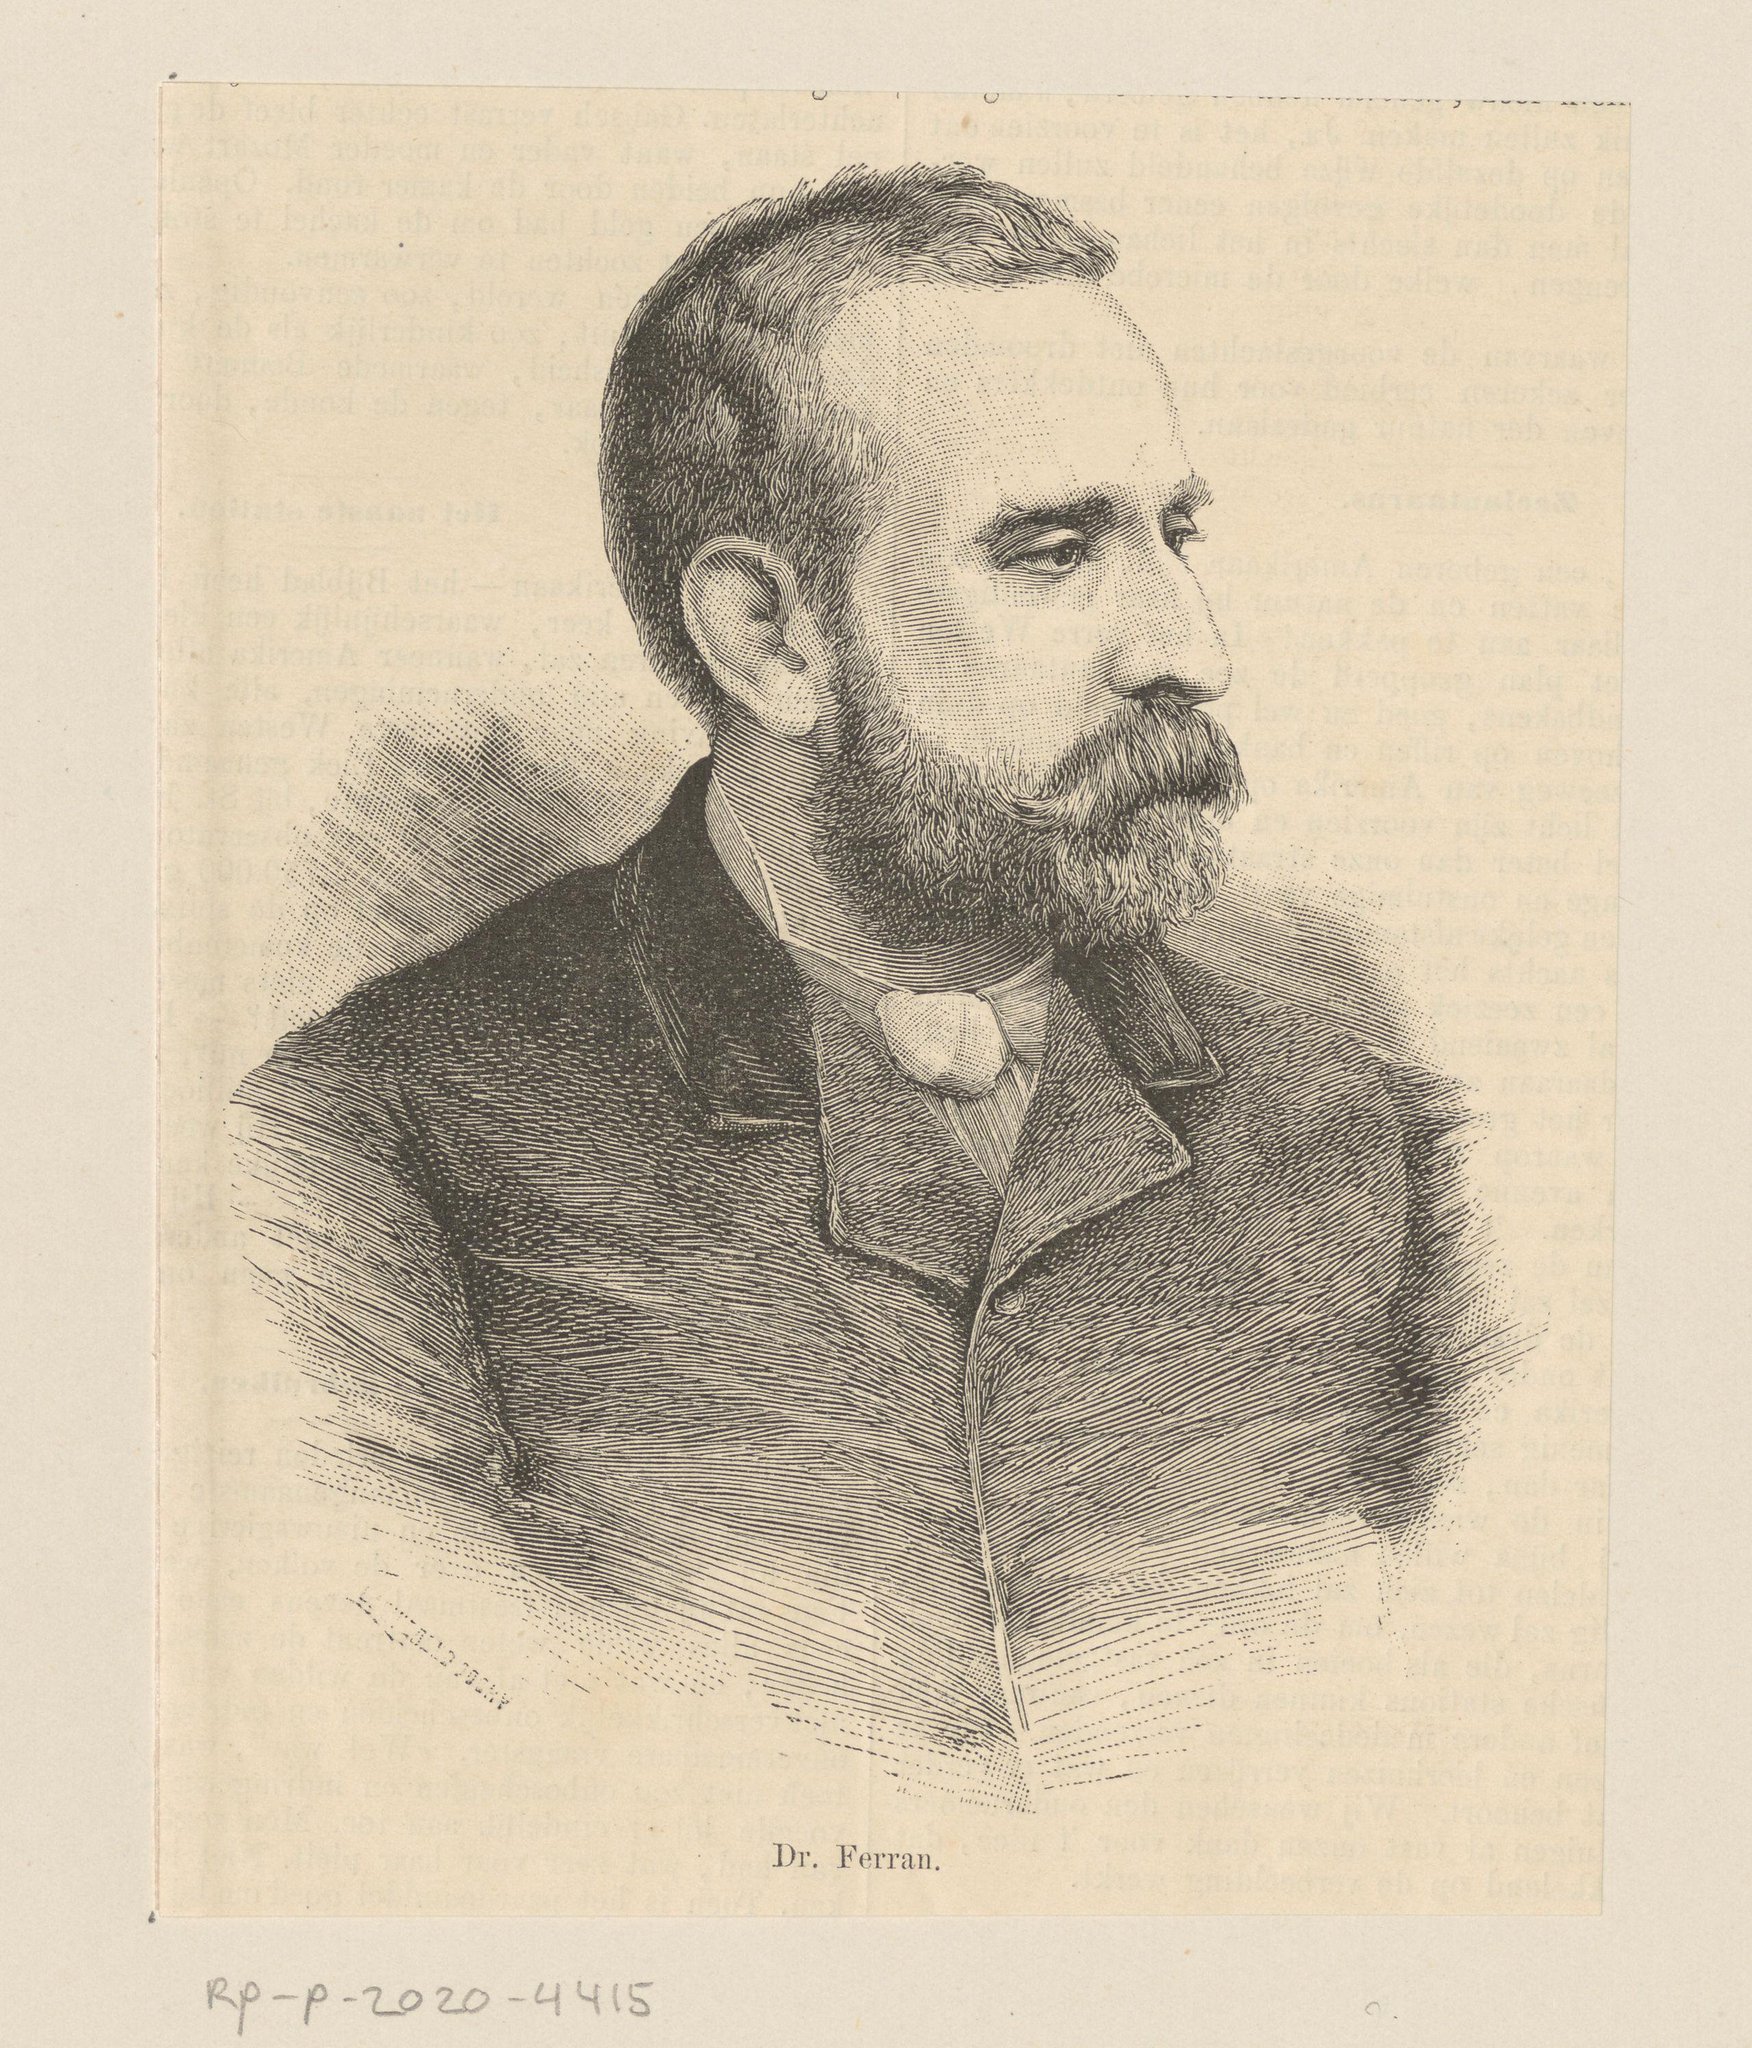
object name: book illustration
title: Portret van Vincent Isidore Pierre Ferran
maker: Anonymous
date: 1850-1900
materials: paper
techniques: letterpress printing, engraving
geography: netherlands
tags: historical persons, physician, doctor (+ portrait of scholar, scientist)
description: Prent komt uit een onbekende publicatie.